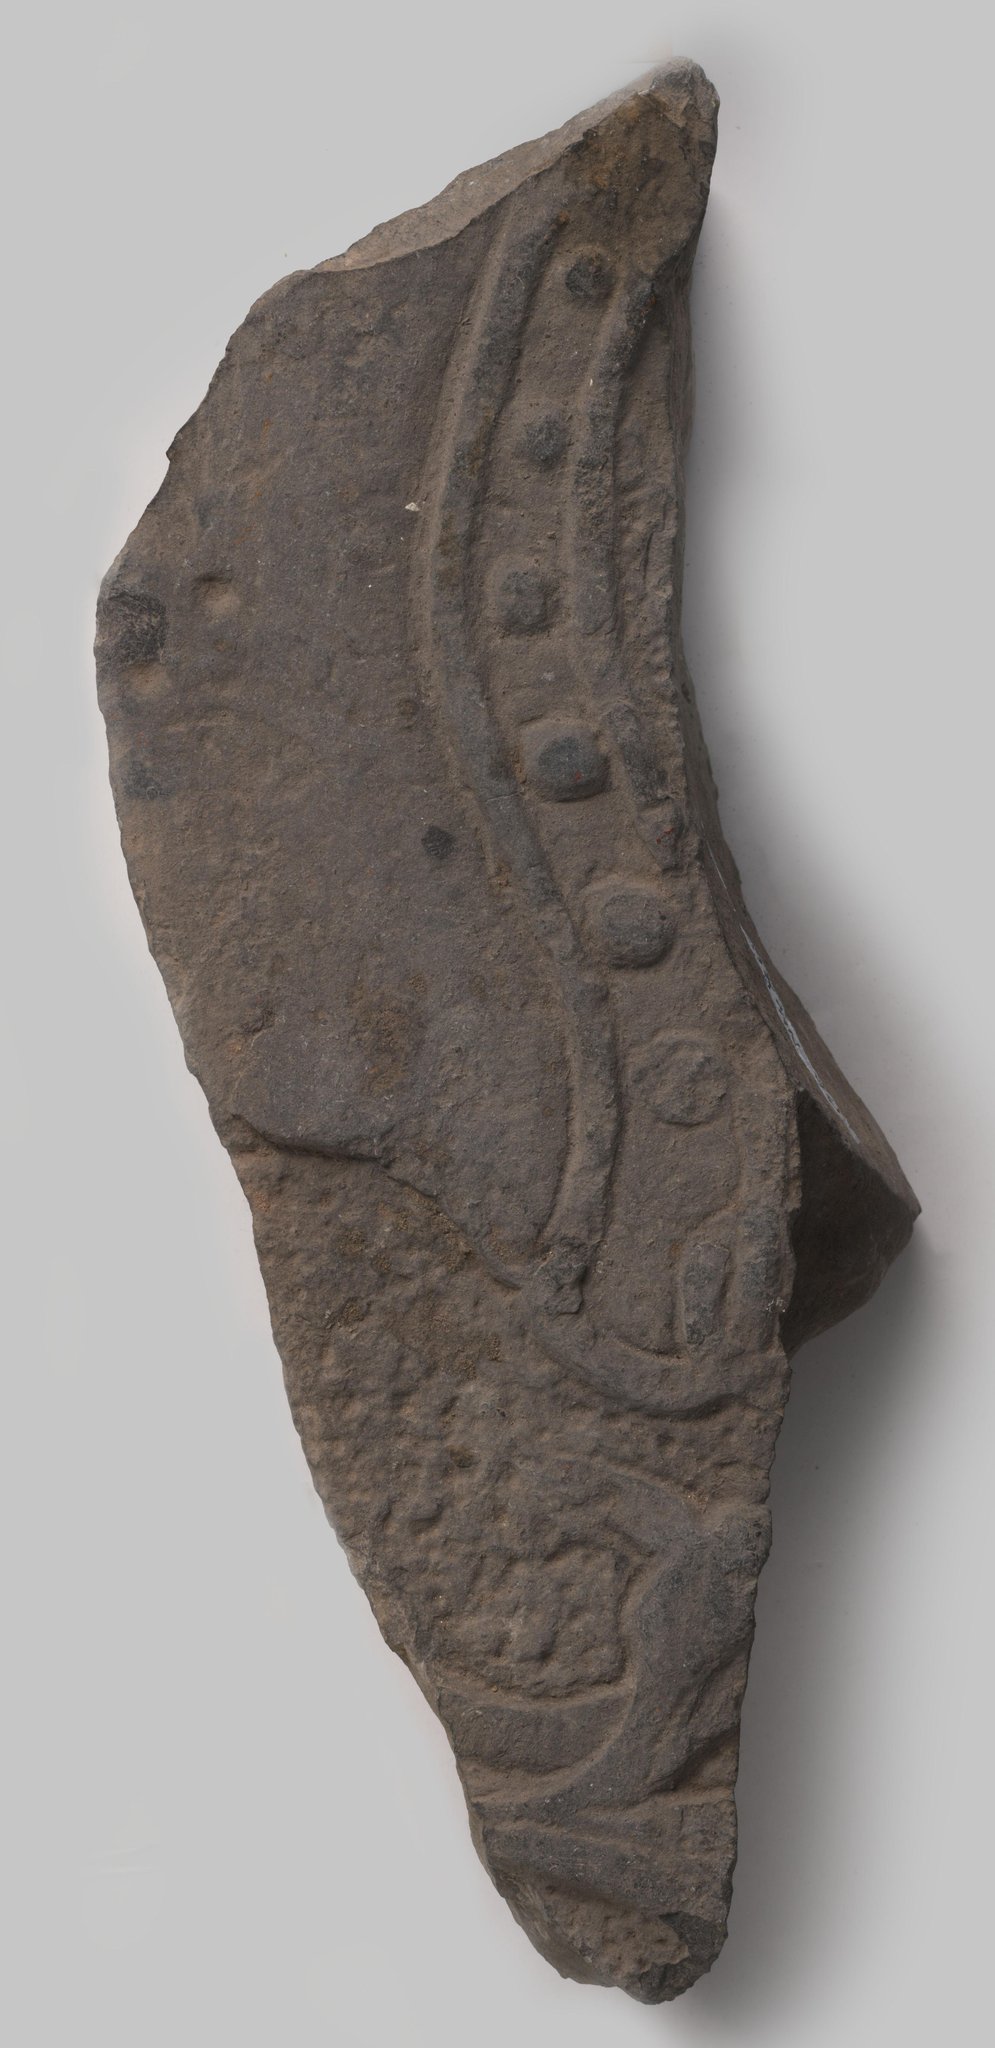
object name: fragment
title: Fragment van een grafzerk met beeldhouwwerk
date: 1497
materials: stone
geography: berne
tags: bern (gelderland)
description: Fragment van het middenveld van de grafzerk van Arent van Malsen. Op het fragment is een band met noppen afgebeeld (deel van de helm). Het fragment hoort bij zeven fragmenten van een incomplete grafzerk (BK-NM-8657-B-1 t/m BK-NM-8657-B-8).